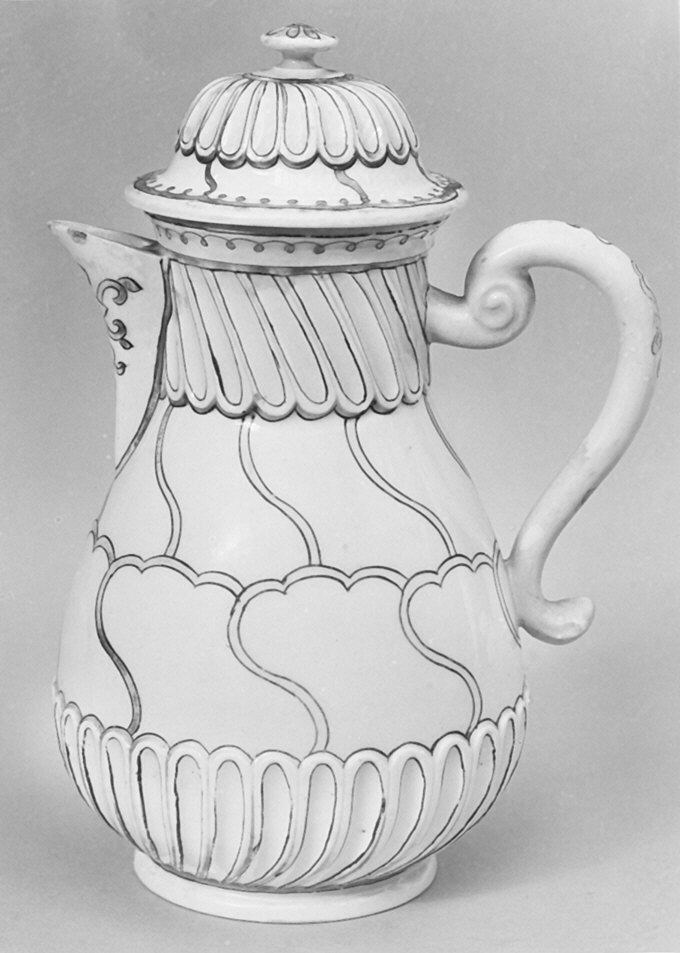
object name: coffeepot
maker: meissen manufactory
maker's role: manufactory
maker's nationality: german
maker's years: 1710-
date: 1725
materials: hard paste porcelain